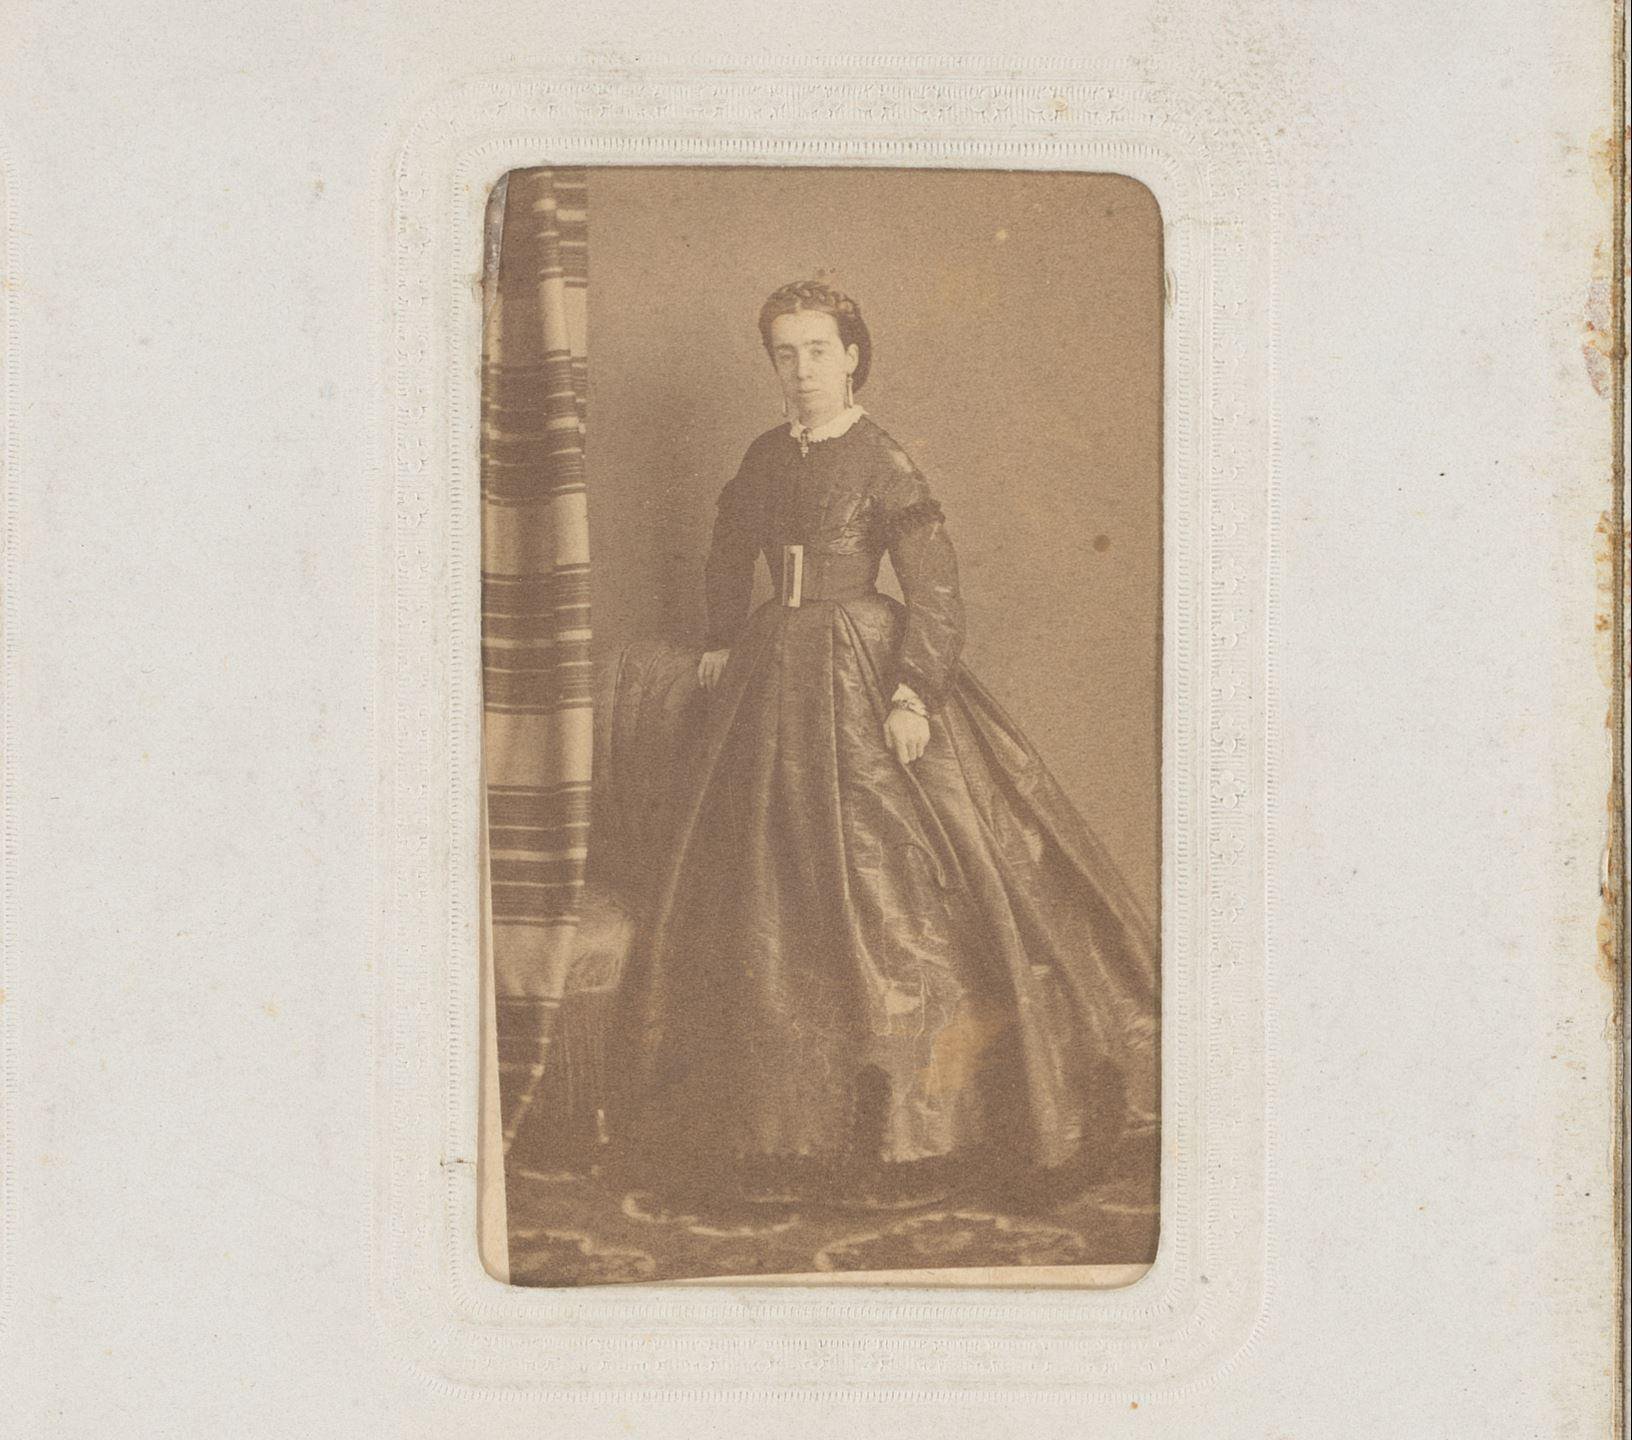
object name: photograph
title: Portret van een vrouw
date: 1860-1890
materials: cardboard, photographic support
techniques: albumen print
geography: zaragoza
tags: historical persons - bb - woman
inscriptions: inscription: ‘Fotografia Zaragozana/ Coso 55’